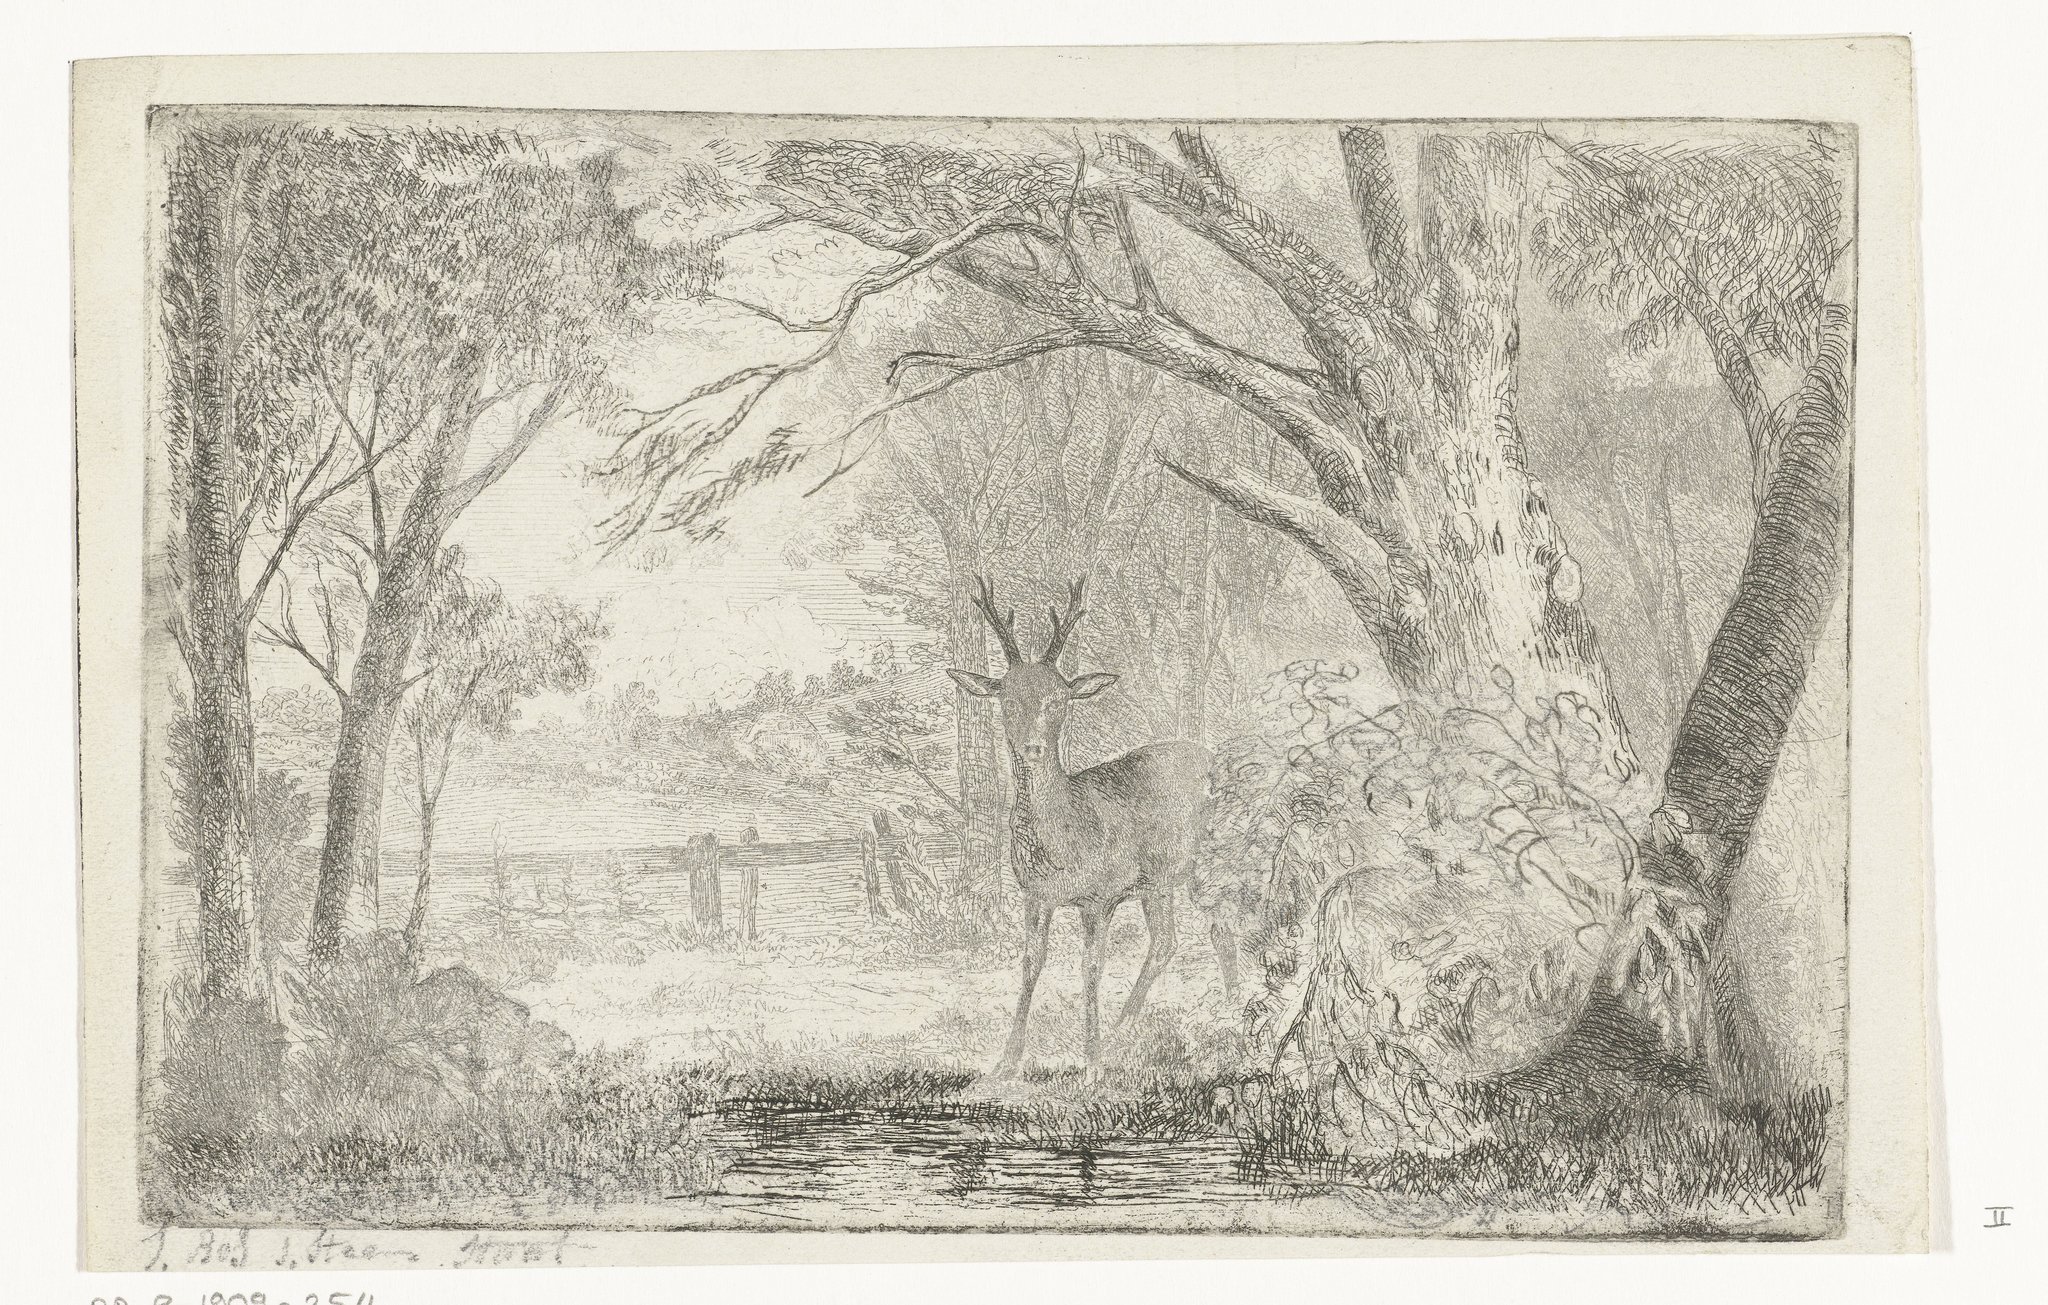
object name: print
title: Parklandschap met hert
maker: jan bos wz.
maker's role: print maker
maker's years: 1832-1897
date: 1890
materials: paper, pencil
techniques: etching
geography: utrecht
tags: park, hoofed animals: deer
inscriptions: signature: ‘J. Bos [...]’, collector's mark: Lugt 2228